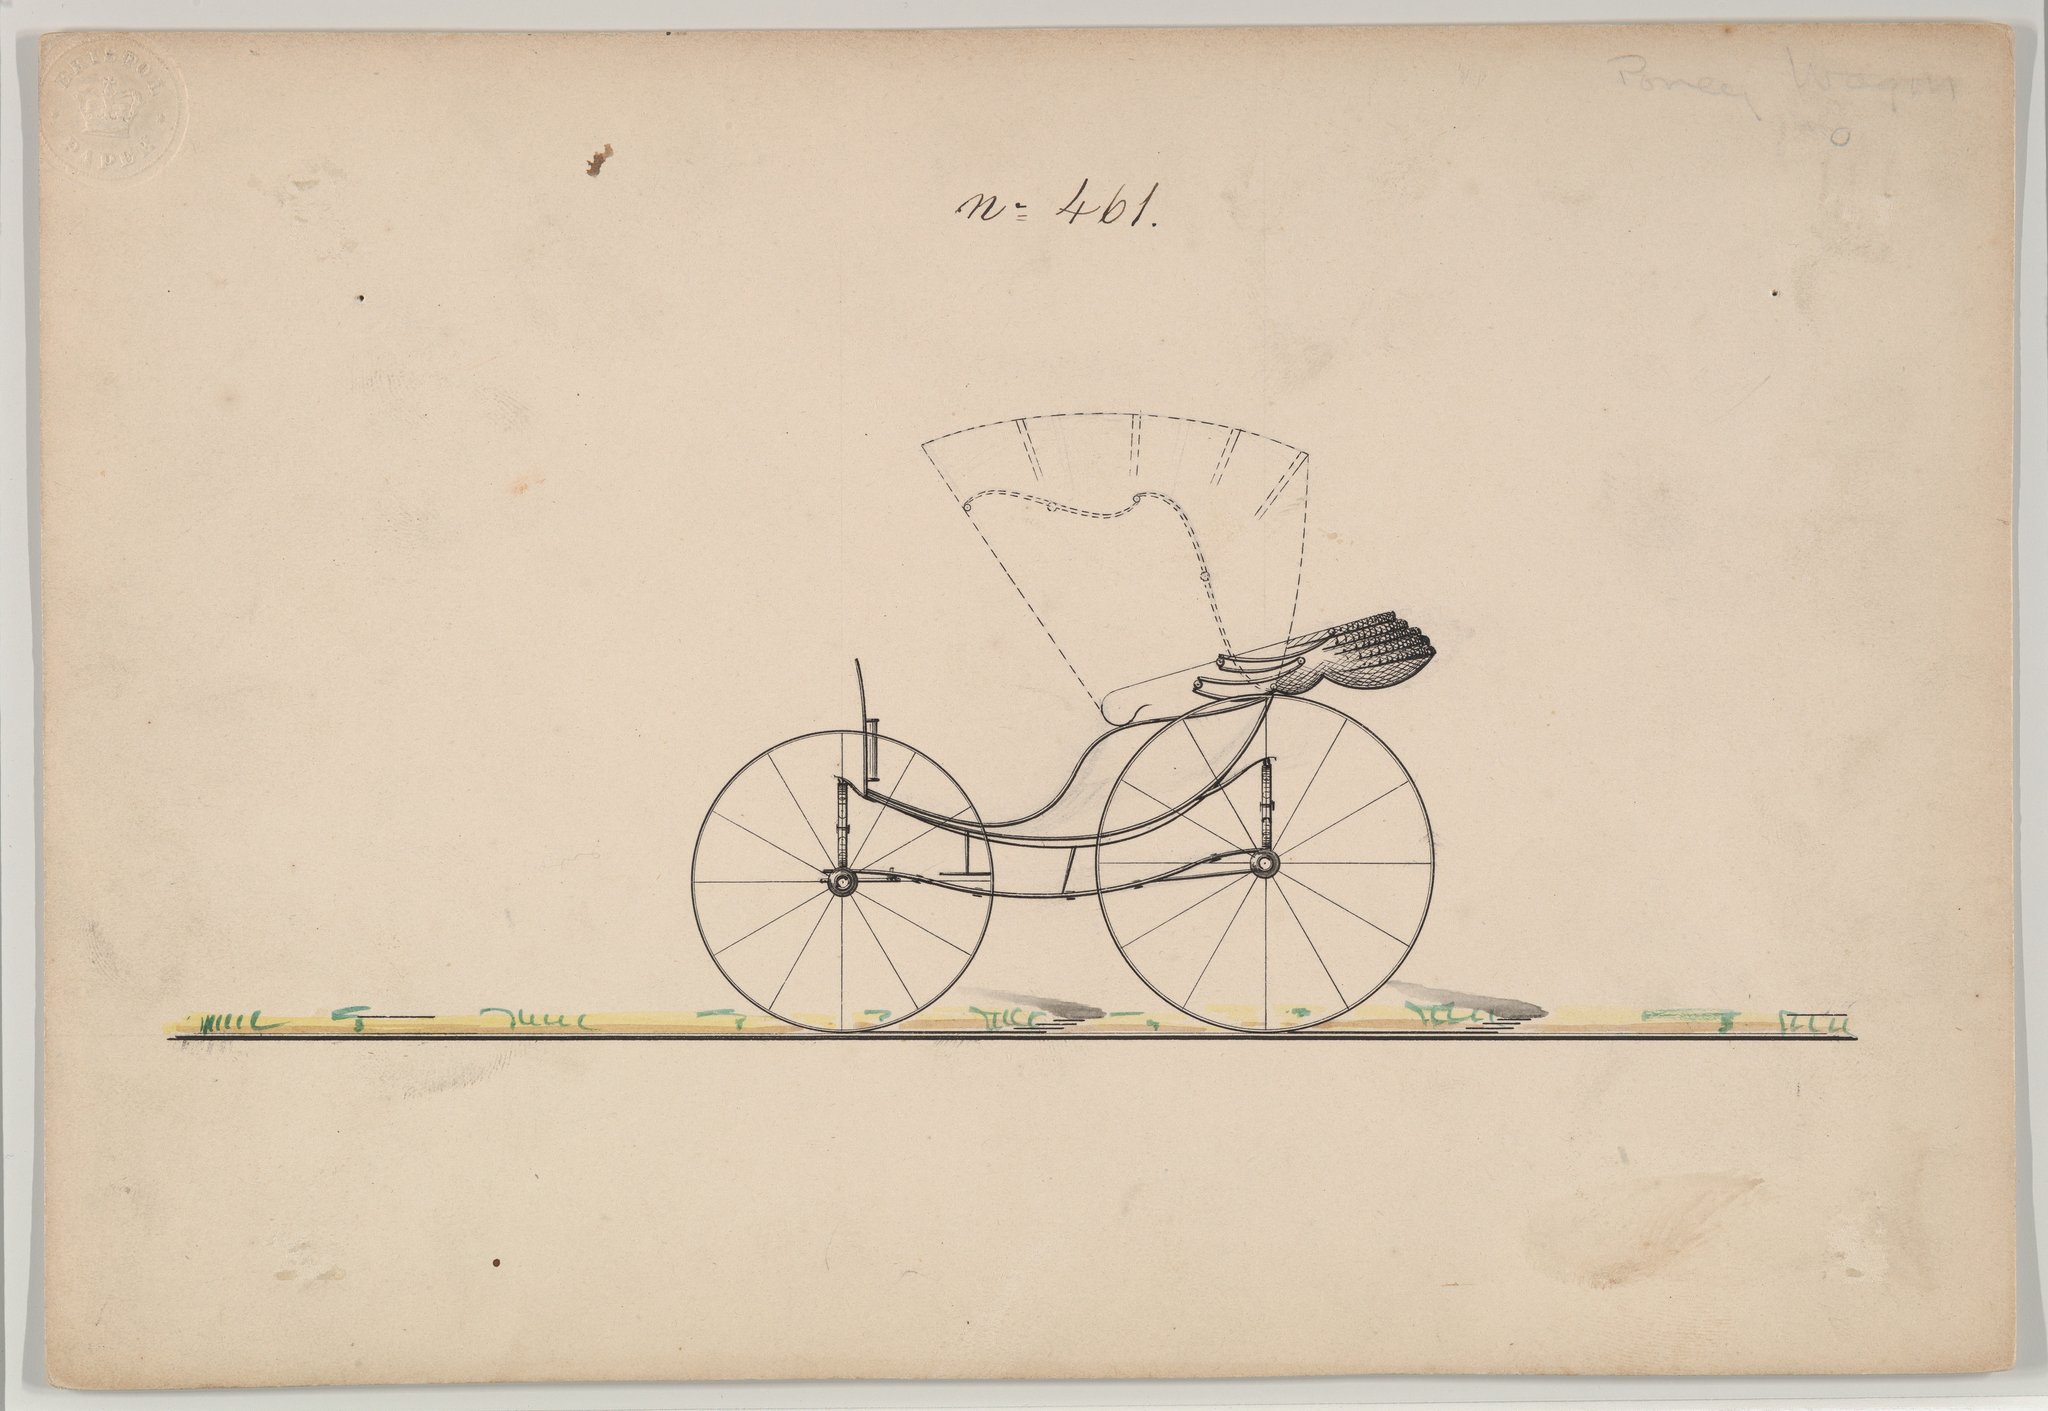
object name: drawing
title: Phaeton #461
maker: brewster & co.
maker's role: manufacturer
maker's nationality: american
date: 1850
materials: ink, watercolor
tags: carriages